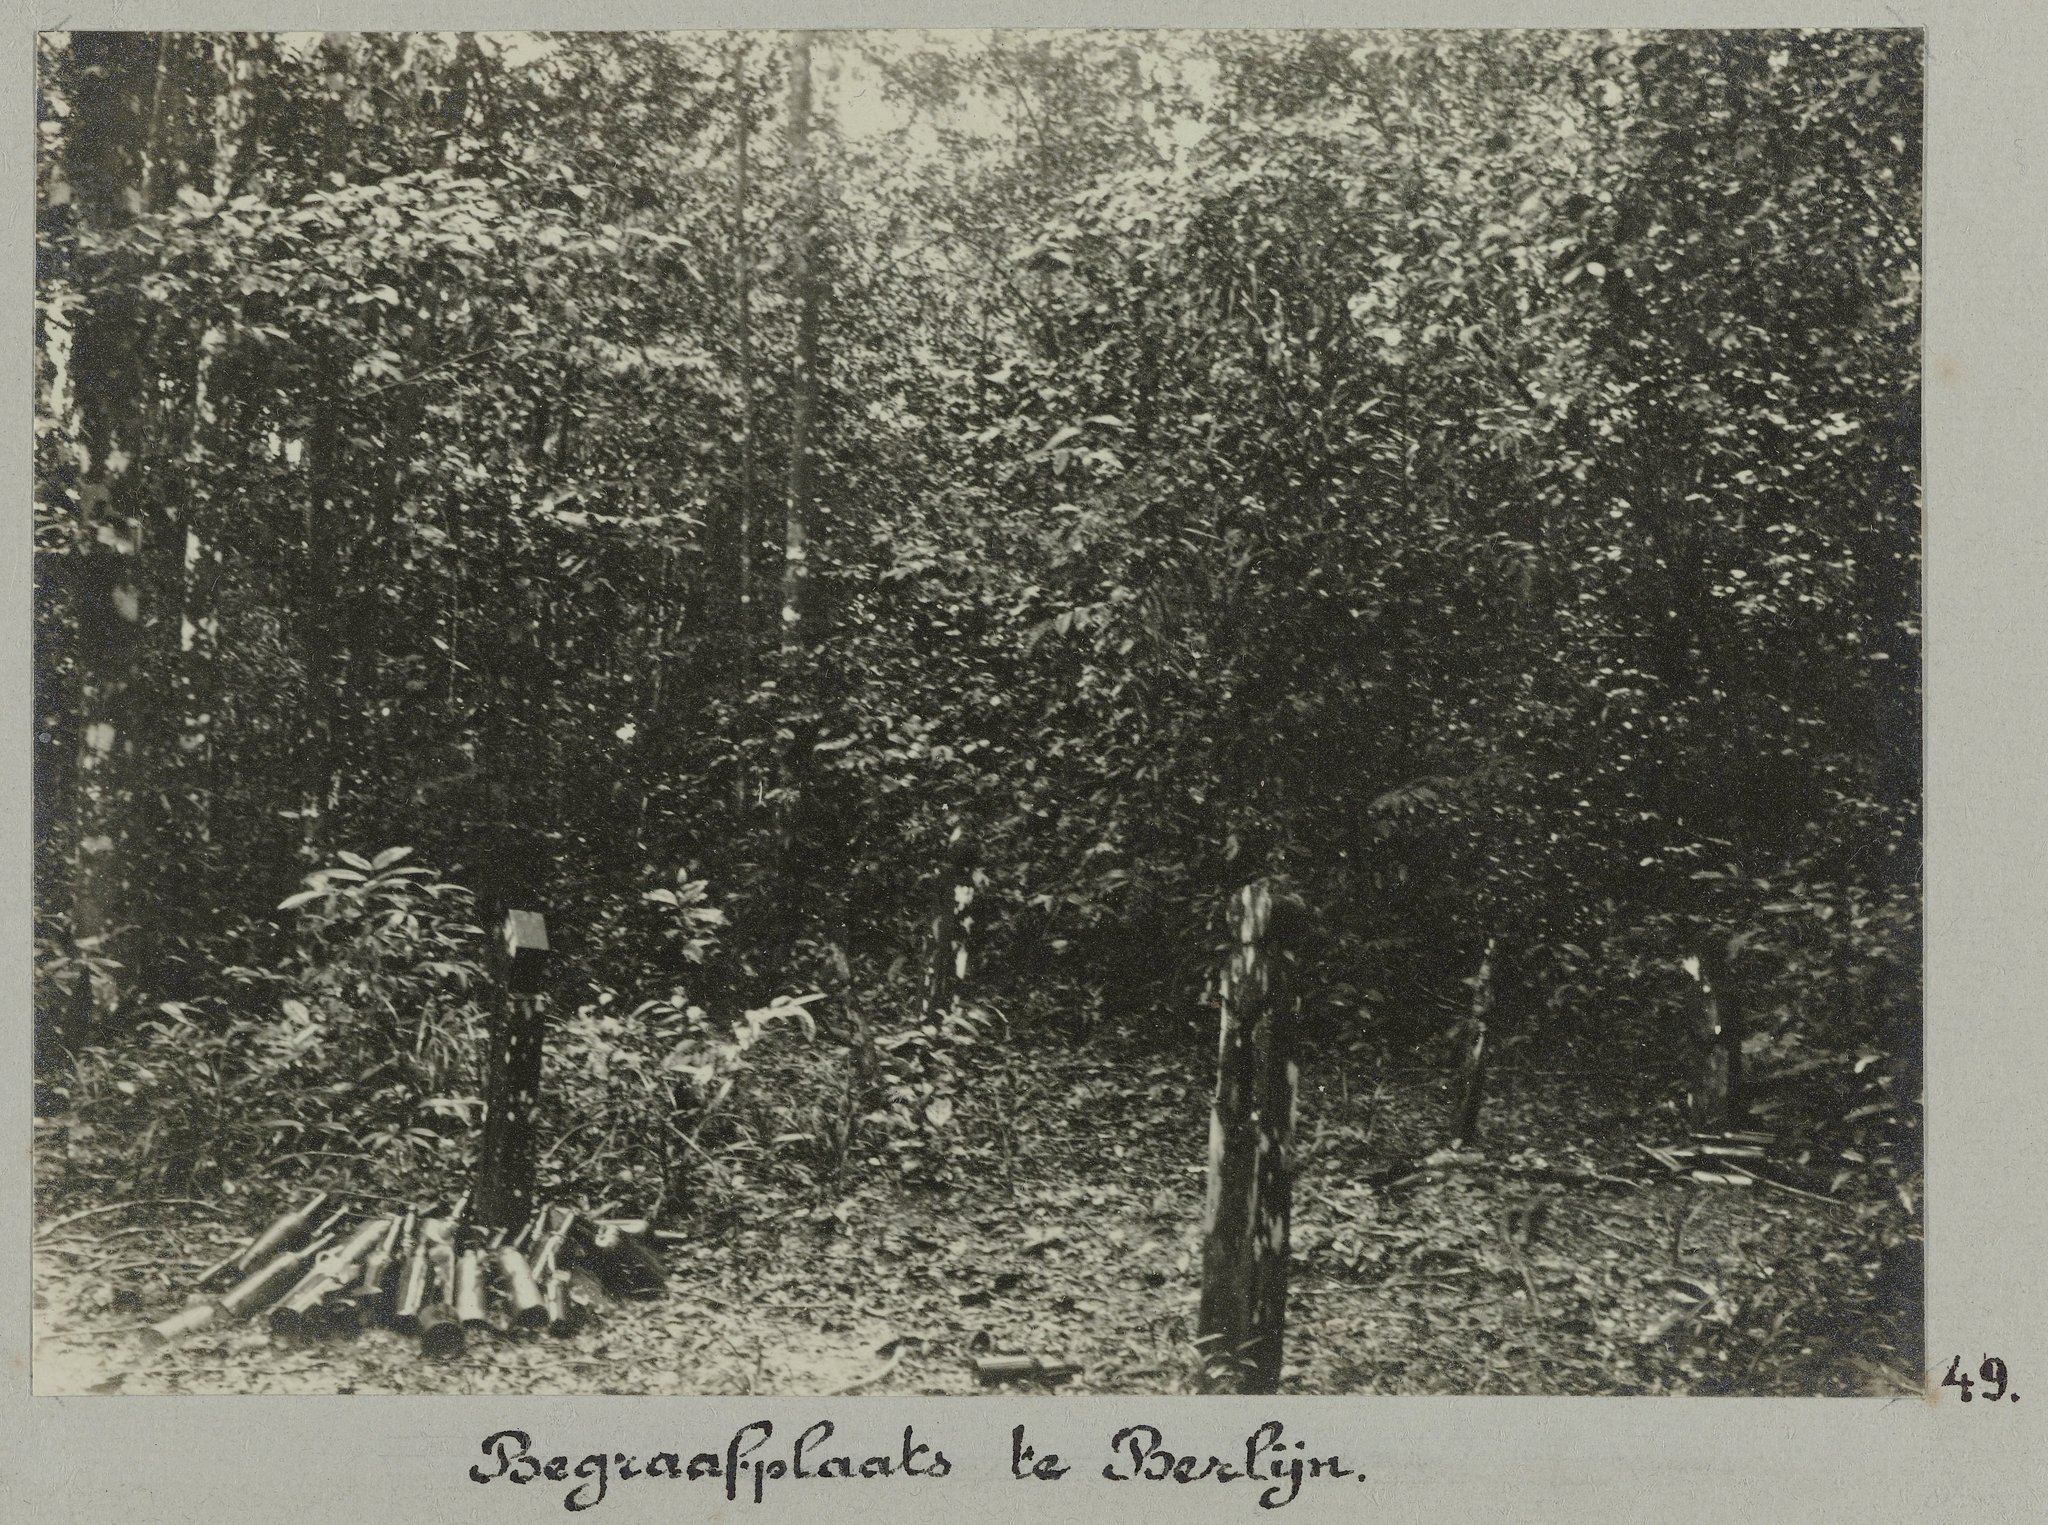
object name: photograph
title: Begraafplaats te Berlijn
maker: hendrik doijer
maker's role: engineer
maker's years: 1863-1925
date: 1903-1910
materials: photographic support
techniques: gelatin silver print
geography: suriname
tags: suriname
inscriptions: inscription: ‘49. / Begraafplaats te Berlijn.’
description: Lokale begraafplaats te Berlijn in Suriname, houten staken in de grond markeren de graven. Onderdeel van het fotoalbum Souvenir de Voyage (deel 2), over het leven van de familie Doijer in en rond de plantage Ma Retraite in Suriname in de jaren 1903-1910.